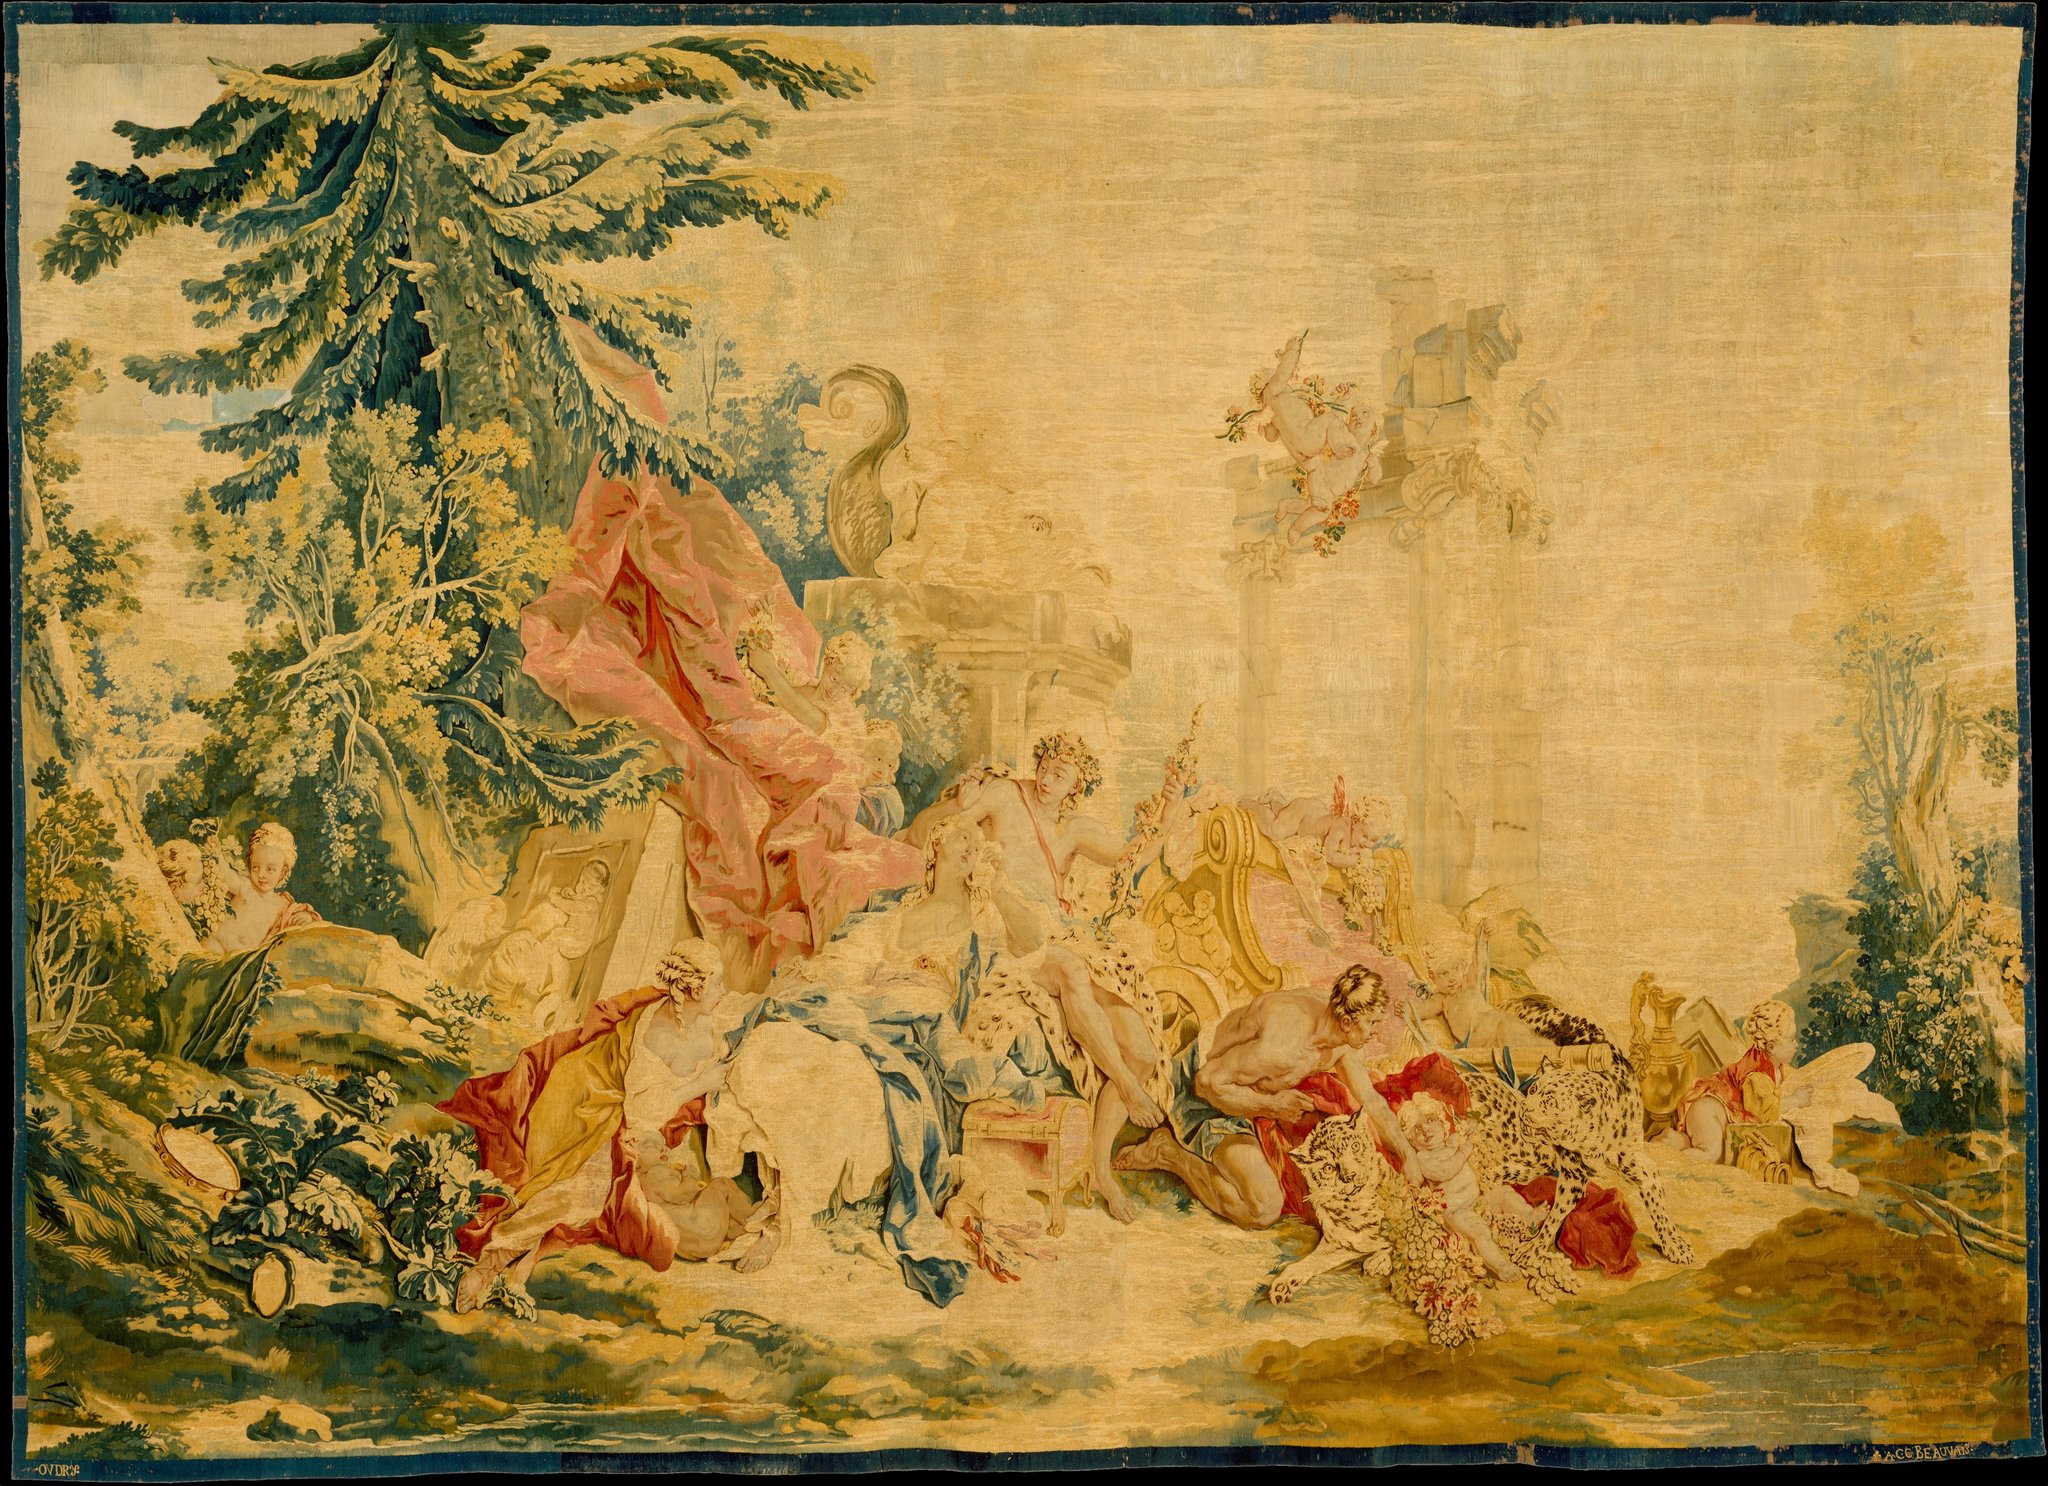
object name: tapestry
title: Bacchus and Ariadne from a set of The Loves of the Gods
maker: françois boucher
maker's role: artist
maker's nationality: french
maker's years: 1703-1770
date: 1754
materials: silk, wool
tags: cupid,ariadne,bacchus,leopards